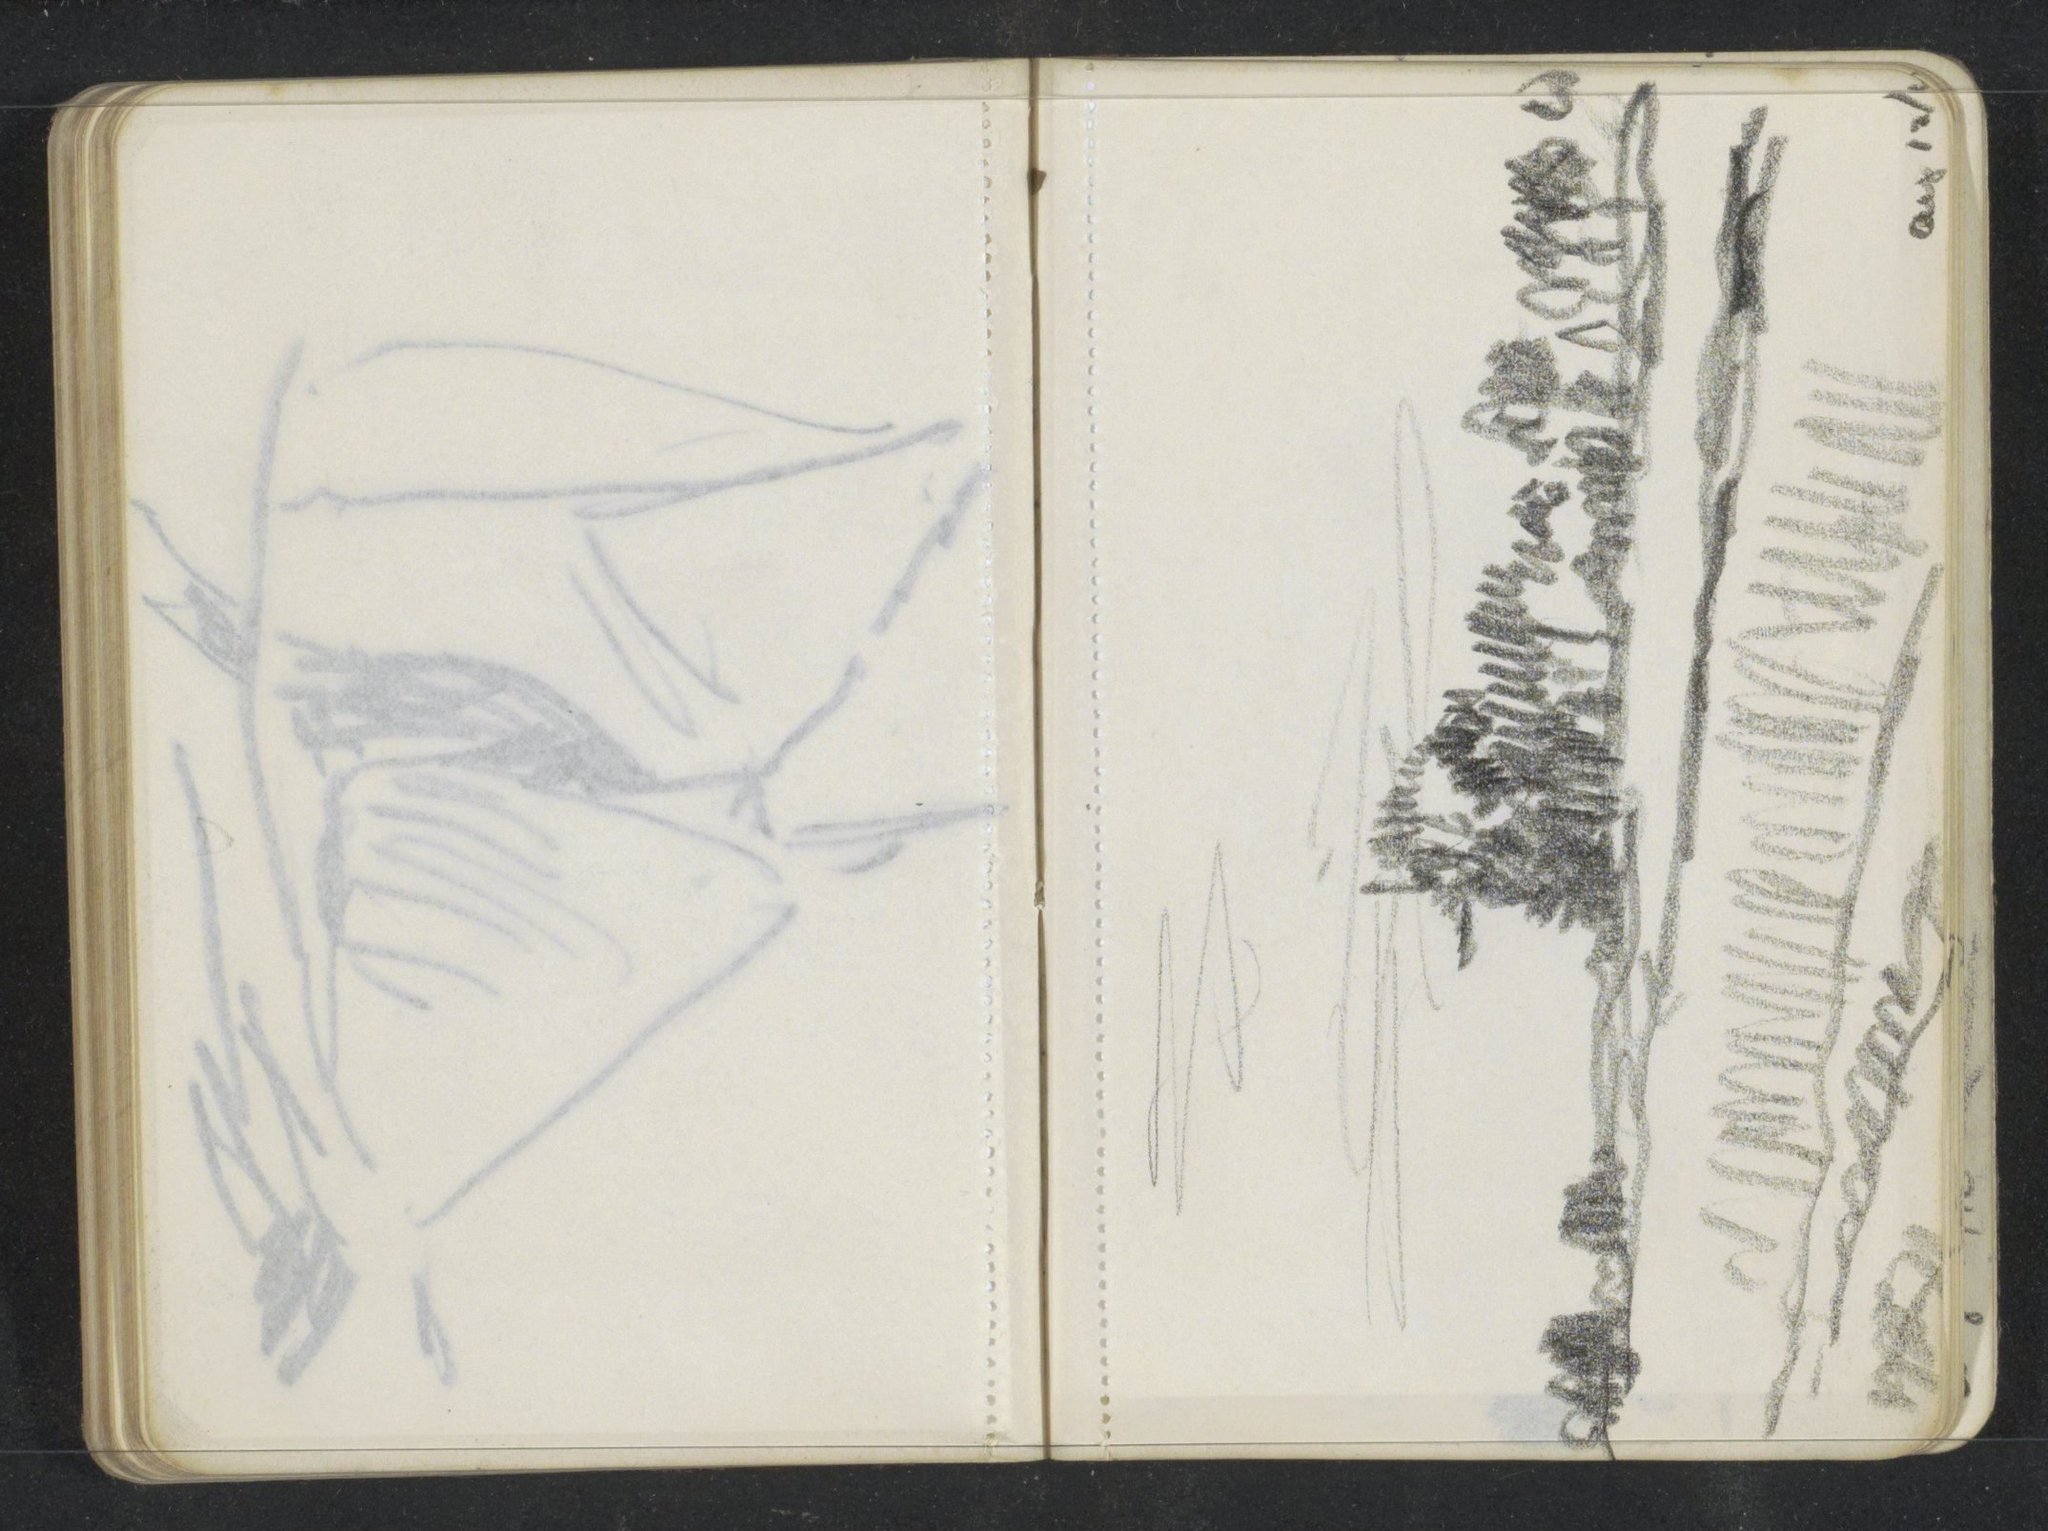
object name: sketchbook leaf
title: Landschap met bomen en een molen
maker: alexander shilling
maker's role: draughtsman, print maker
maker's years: 1859-1937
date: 1908-1910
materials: paper, pencil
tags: windmill in landscape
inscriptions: date: ‘aug 12/10’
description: Blad 59 recto uit een schetsboek met 91 bladen.